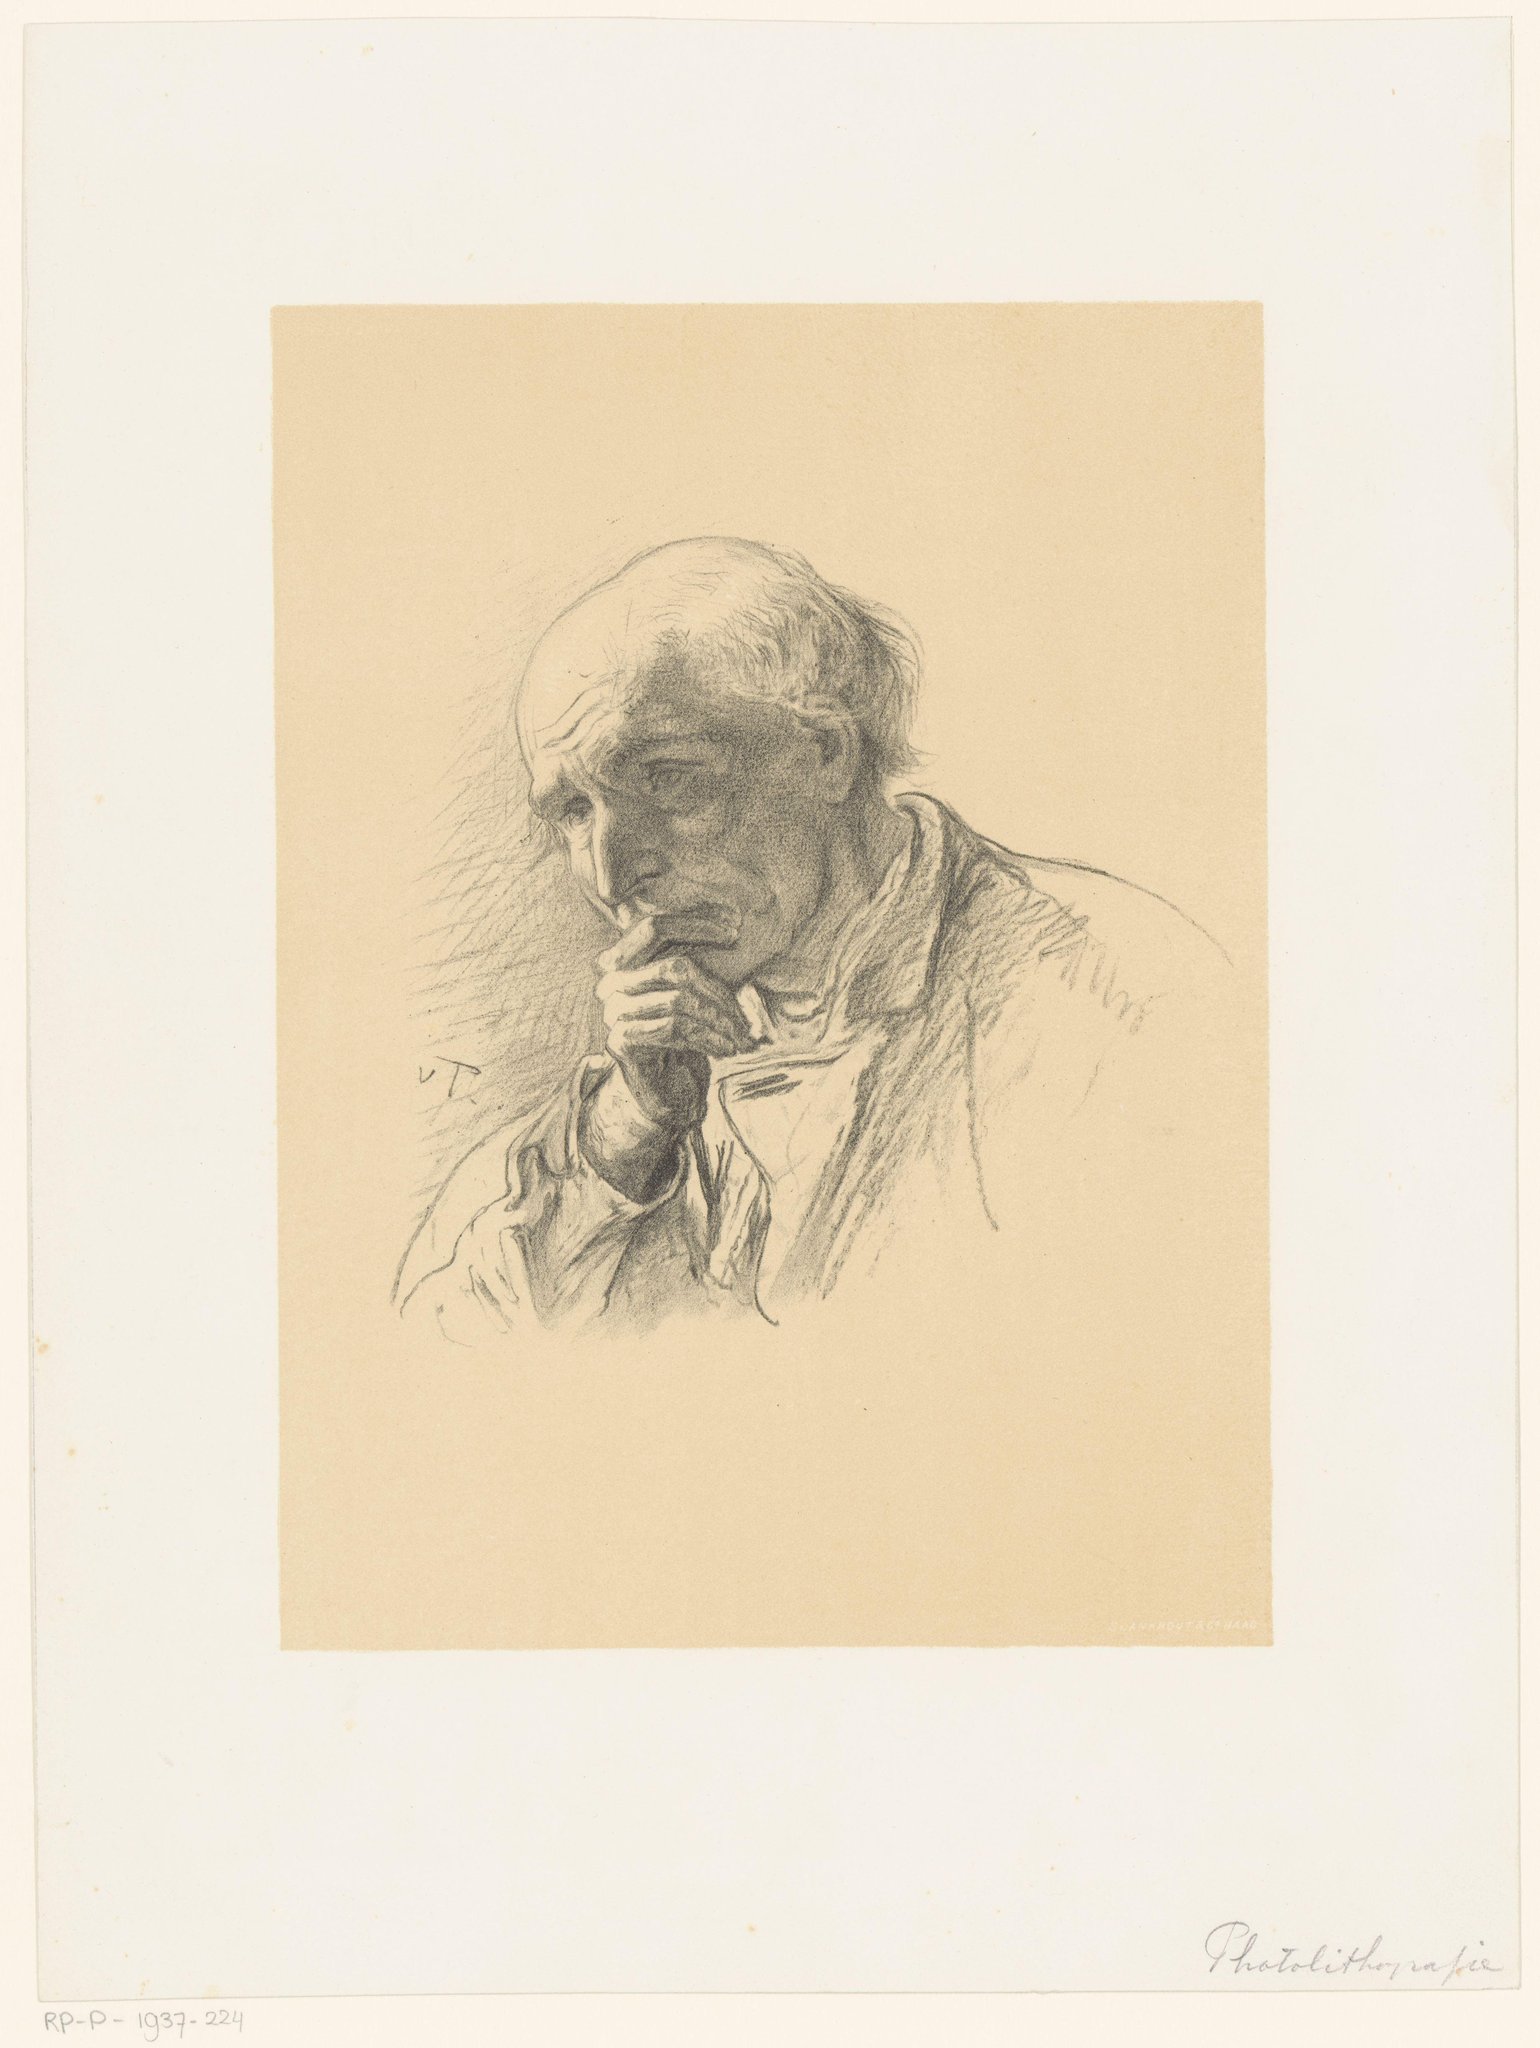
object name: print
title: Nadenkende oude man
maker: hendrik albert van trigt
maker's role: draughtsman, painter, print maker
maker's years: 1829-1899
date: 1877-1899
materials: paper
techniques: photolithography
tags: thinking, thought, reflection; 'pensiero' (ripa)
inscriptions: collector's mark: Lugt 2760, collector's mark: Lugt 2228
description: Een oude man kijkt peinzend voor zich uit.